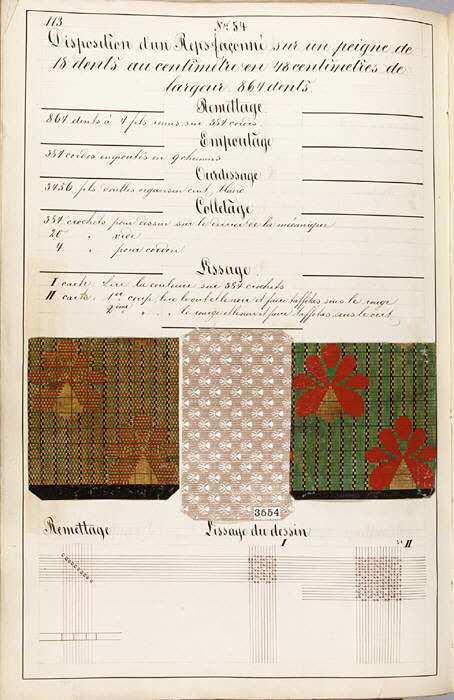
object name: apprentice book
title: Théorie de la fabrication des étoffes de soie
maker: emile klingholz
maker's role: author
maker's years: 1800-1900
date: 1846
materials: paper, silk